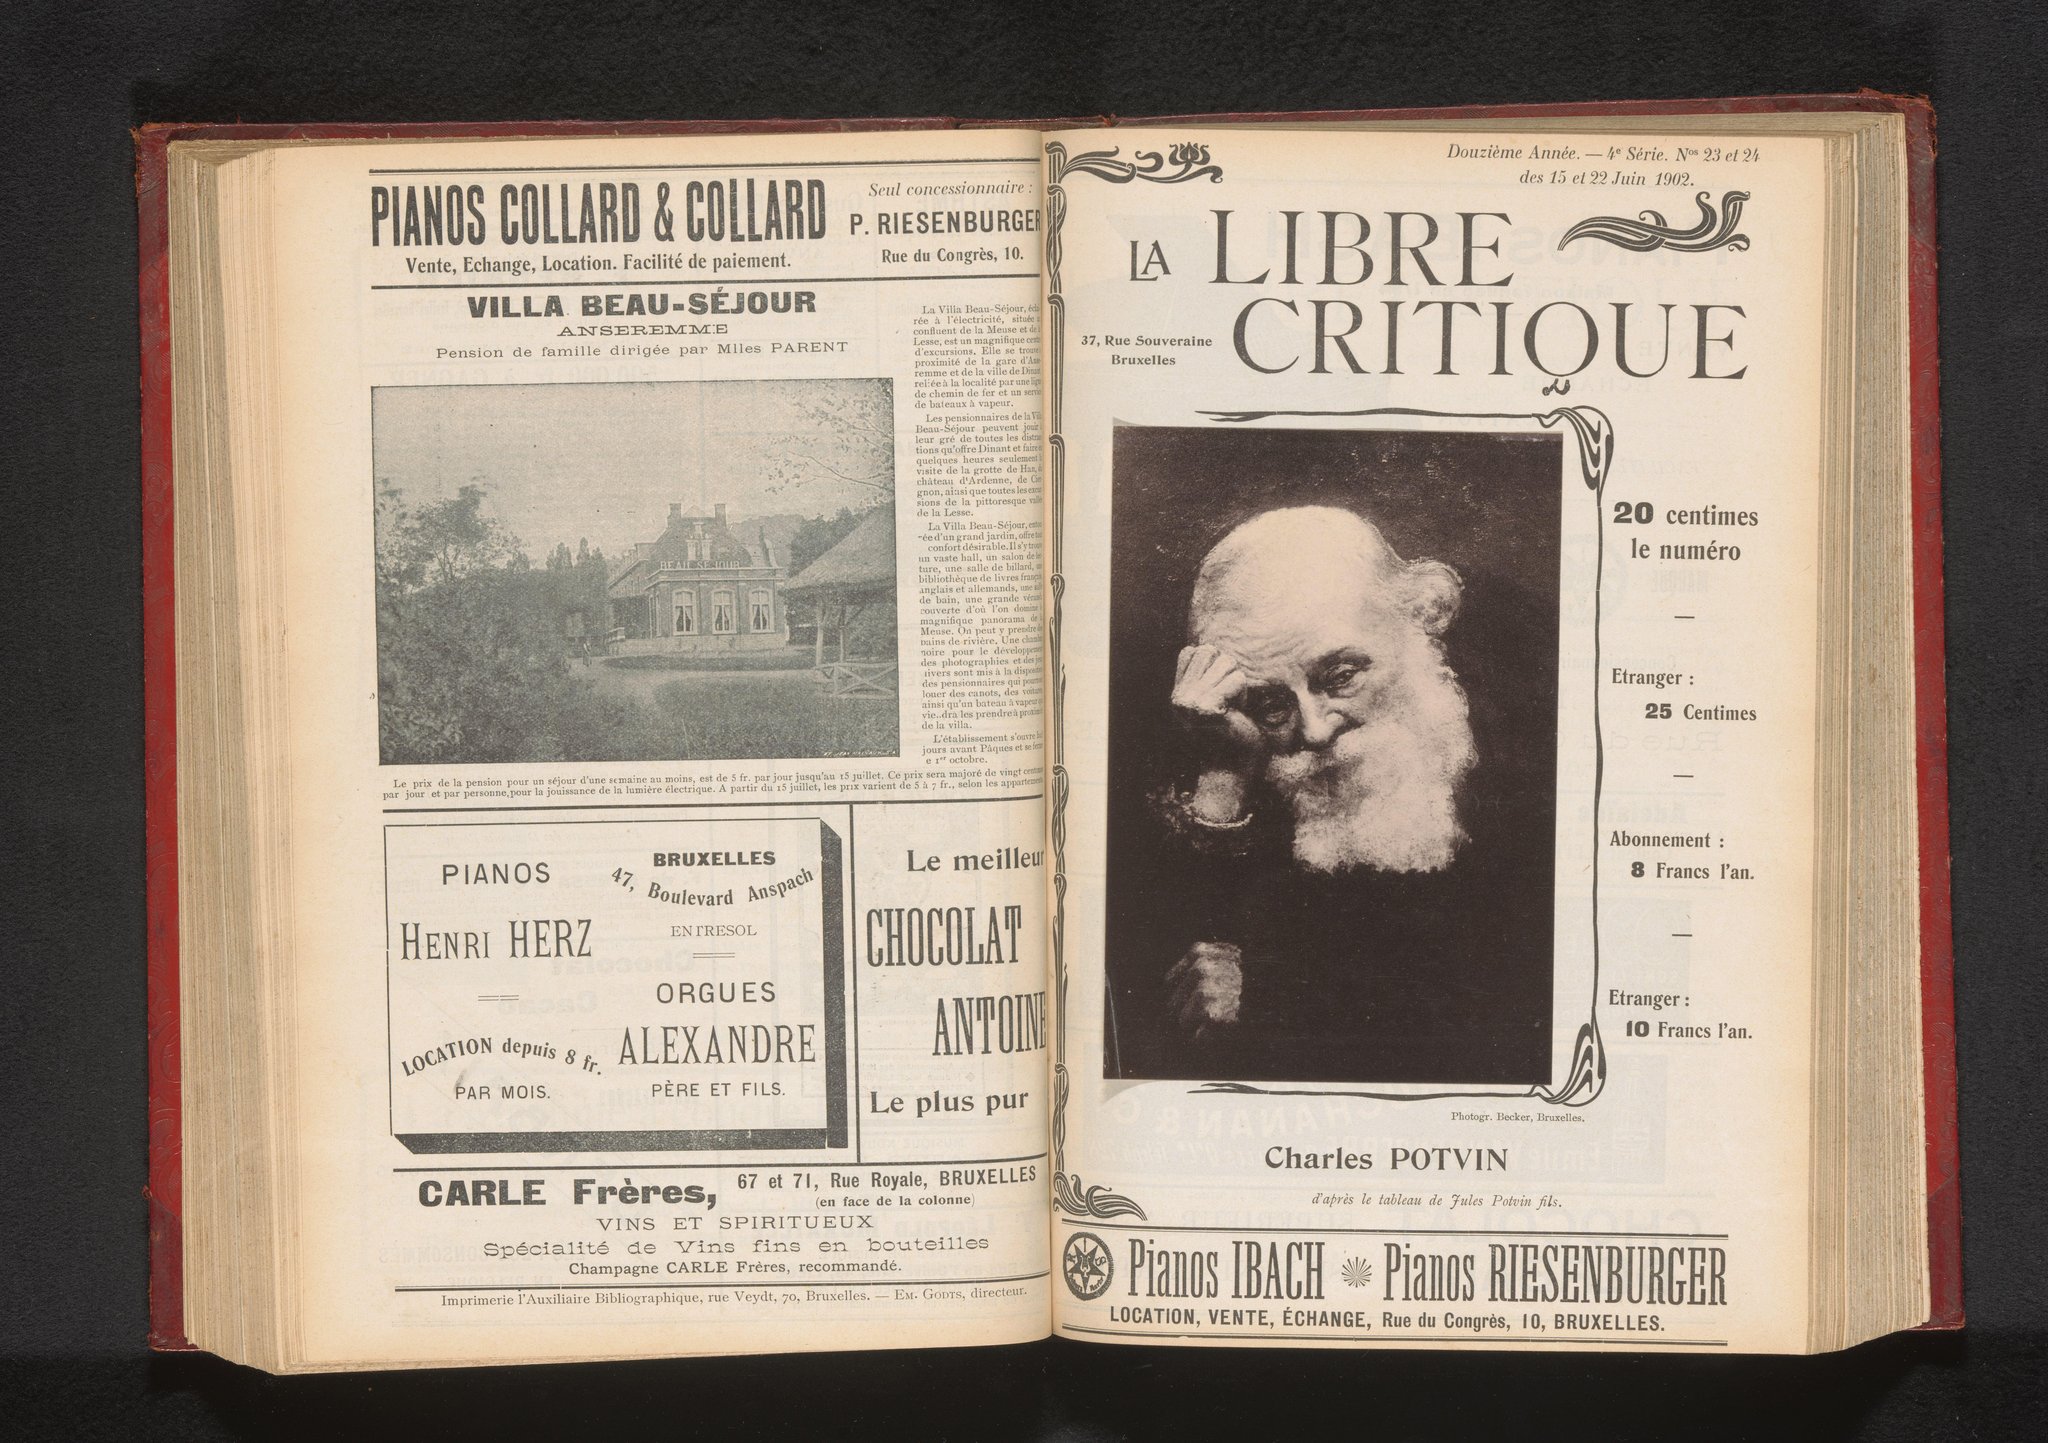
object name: photomechanical print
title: Charles Potvin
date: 1897-1902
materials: paper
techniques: photograph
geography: brussels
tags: charles potvin, scholar, philosopher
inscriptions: inscription: ‘d'apres le tableau de Jules Potvin fils.’